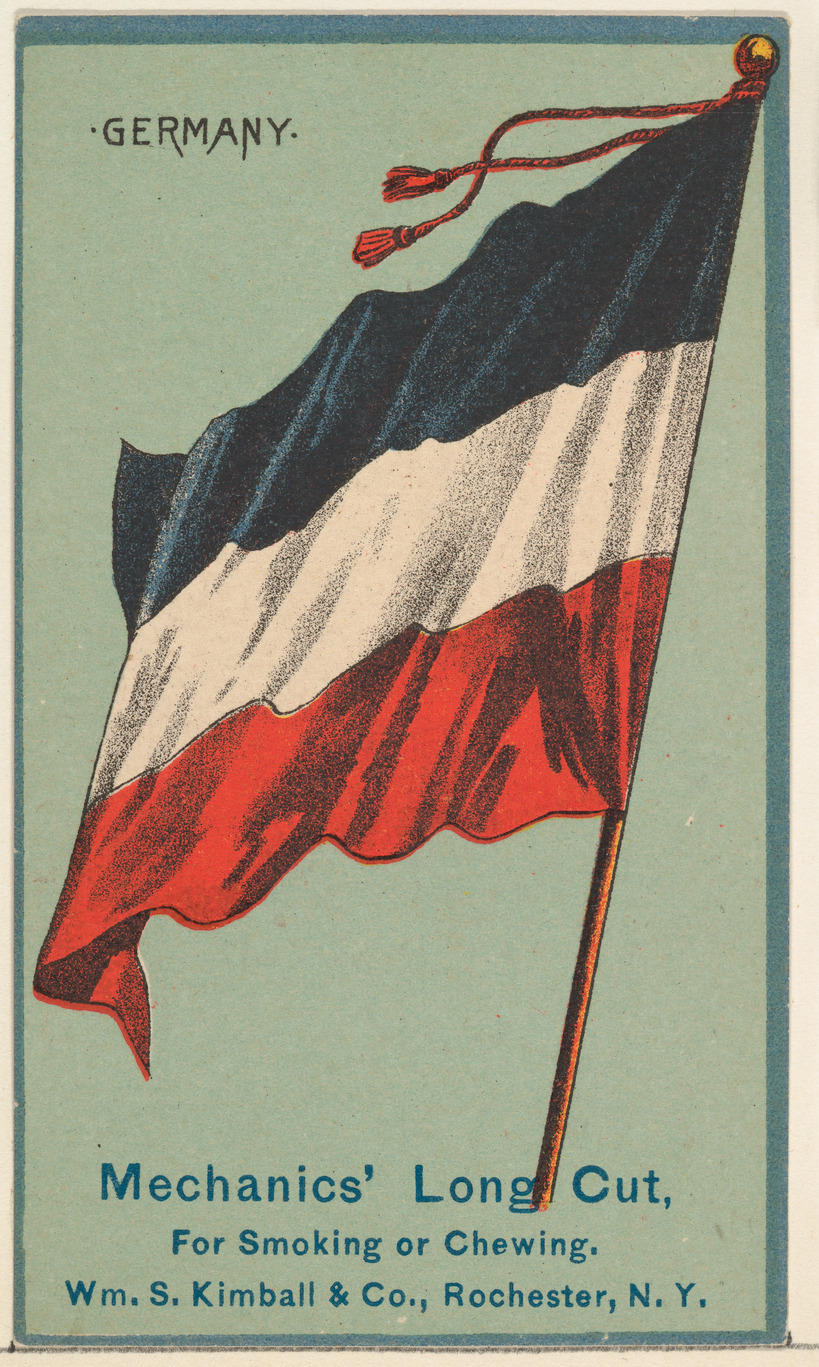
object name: print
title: Germany, from the National Flags series (N195) issued by Wm. S. Kimball & Co.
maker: william s. kimball & company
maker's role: publisher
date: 1891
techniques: color lithograph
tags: flags